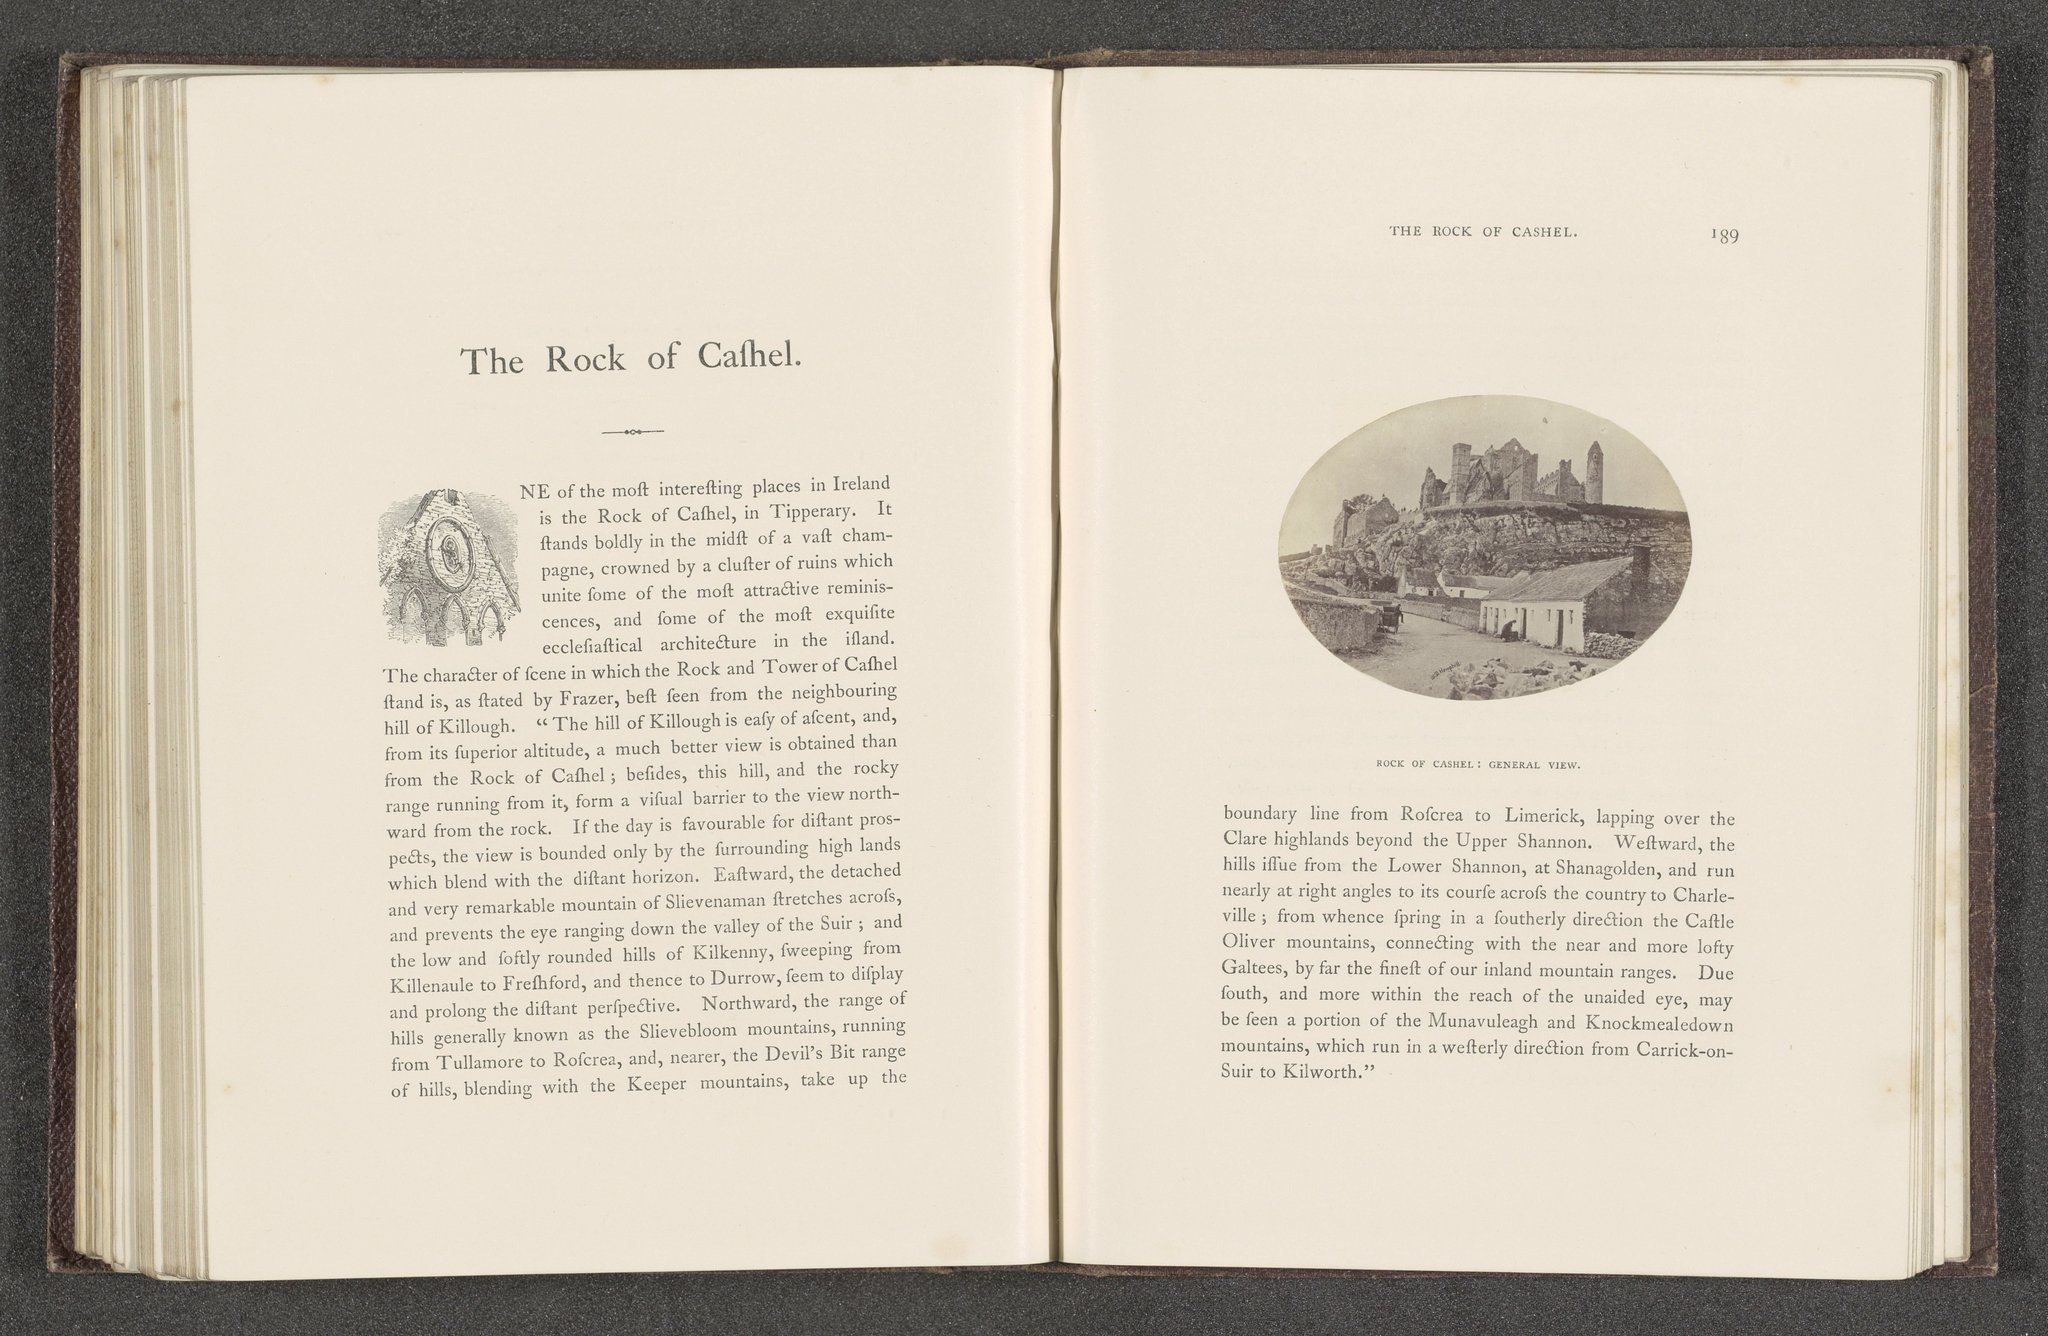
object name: page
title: Gezicht op de Rock of Cashel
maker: hemphill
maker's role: fotograaf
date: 1854-1864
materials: photographic support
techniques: albumen print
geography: cashel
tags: ruin of church, monastery, etc.